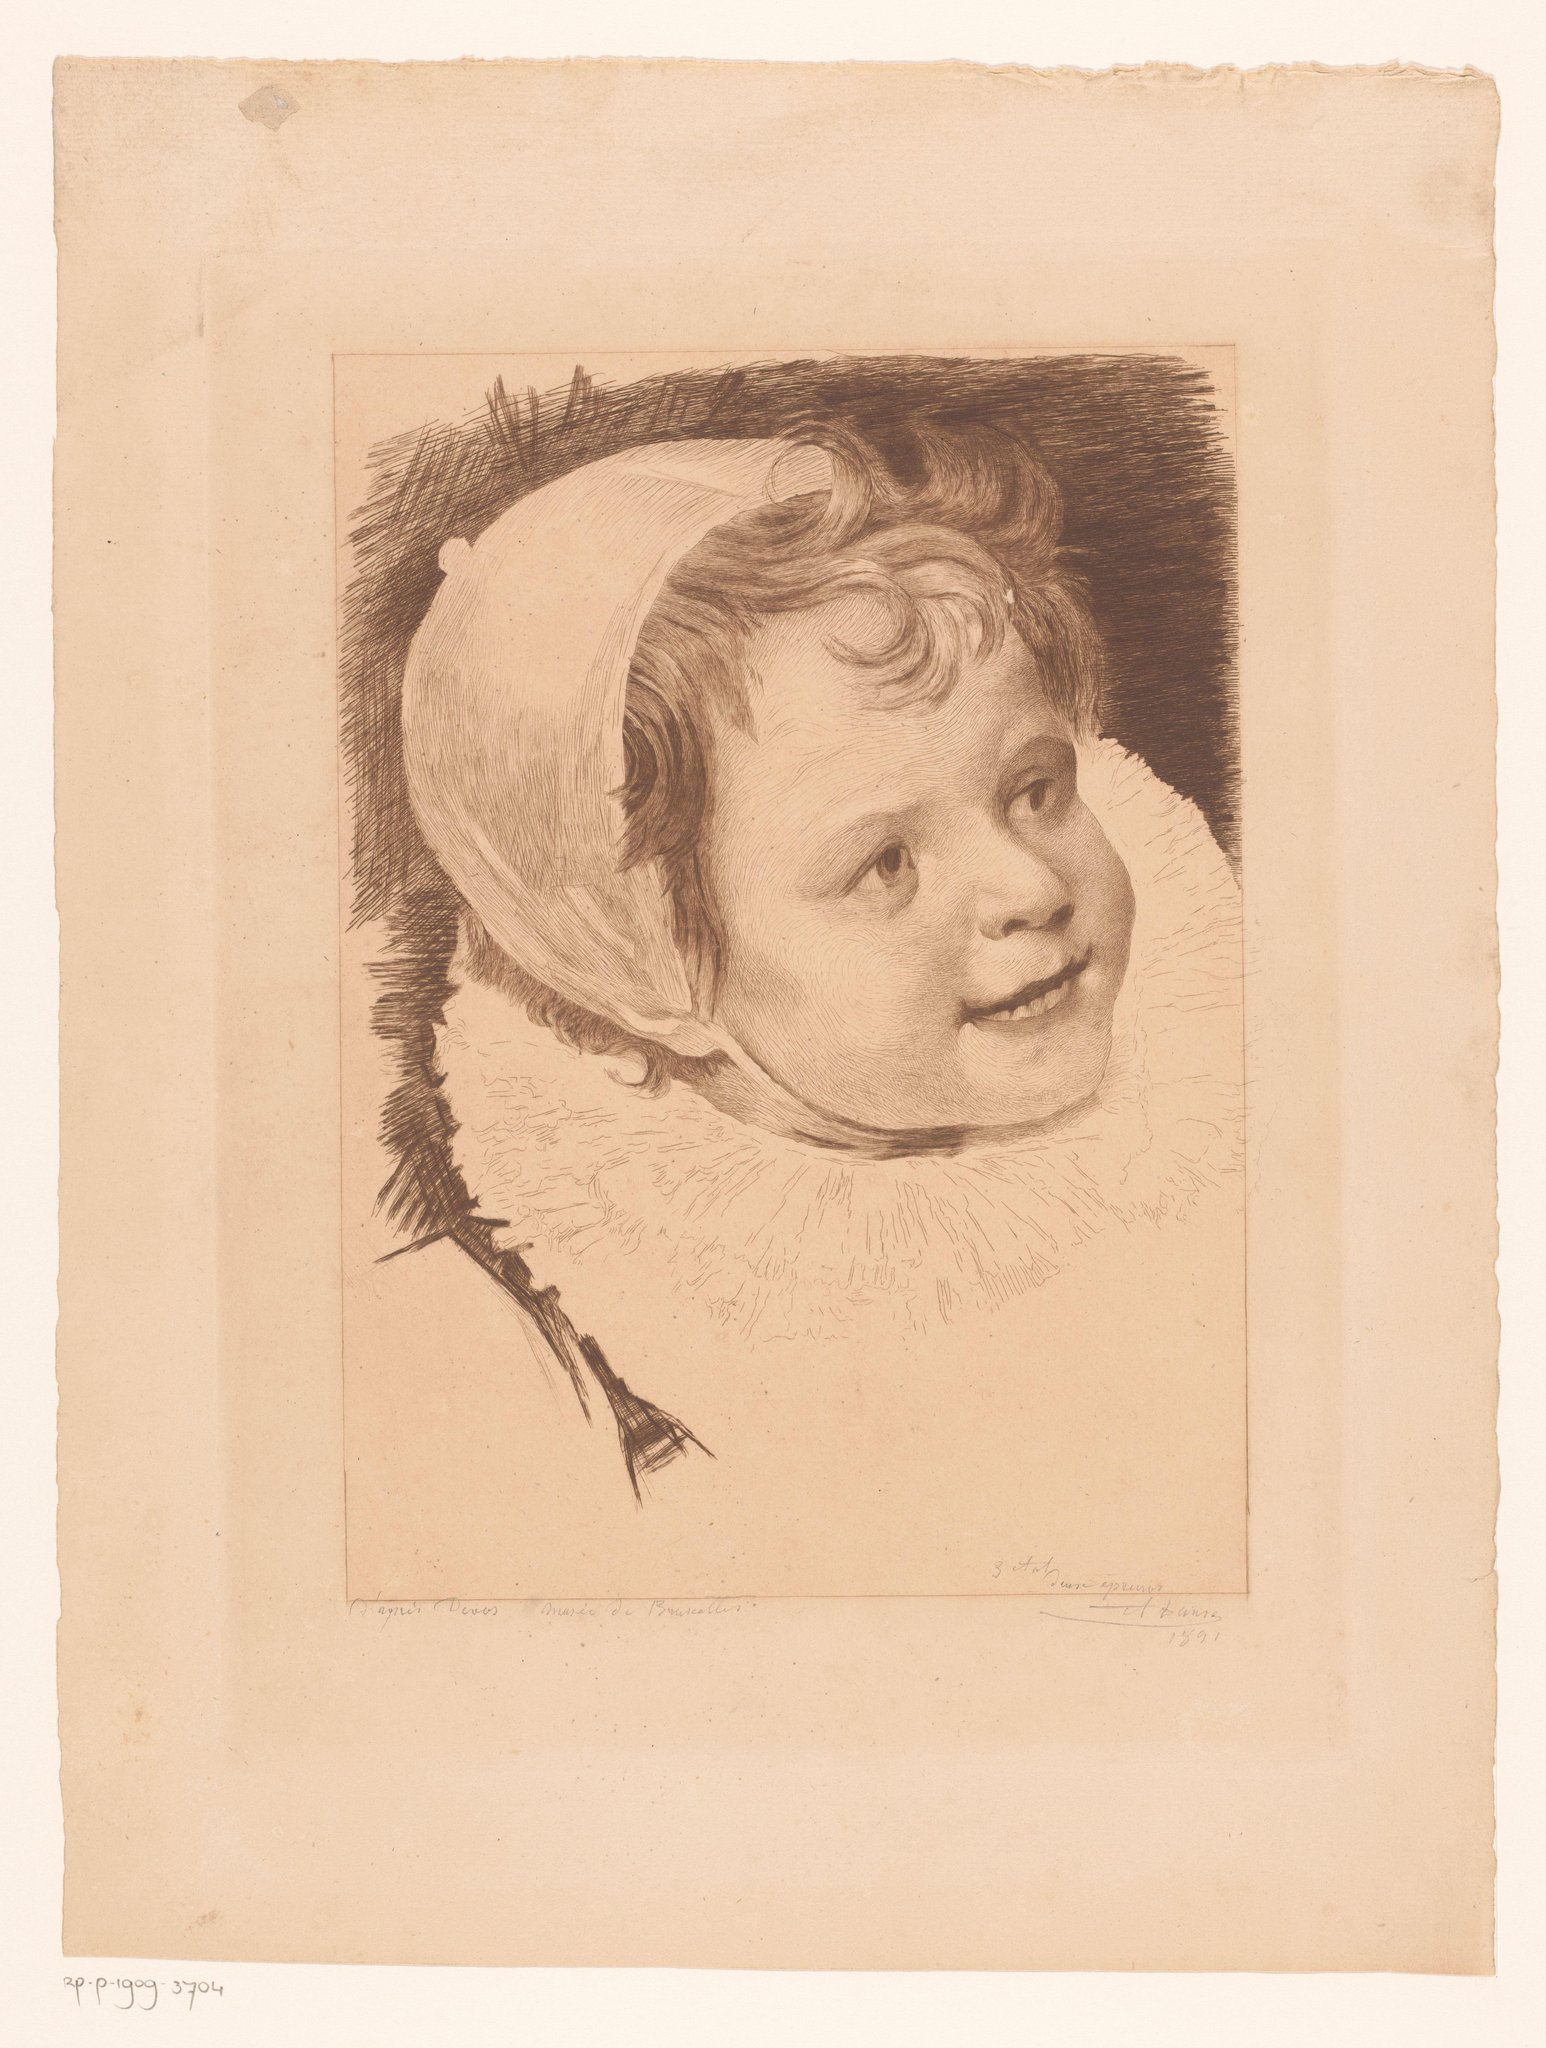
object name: print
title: Portret van Johannes-Baptist de Vos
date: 1891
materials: paper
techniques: drypoint, etching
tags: antwerp, boy (child between toddler and youth)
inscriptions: collector's mark, o: Lugt 2228, annotation: ‘3 etat; deux épreuves’